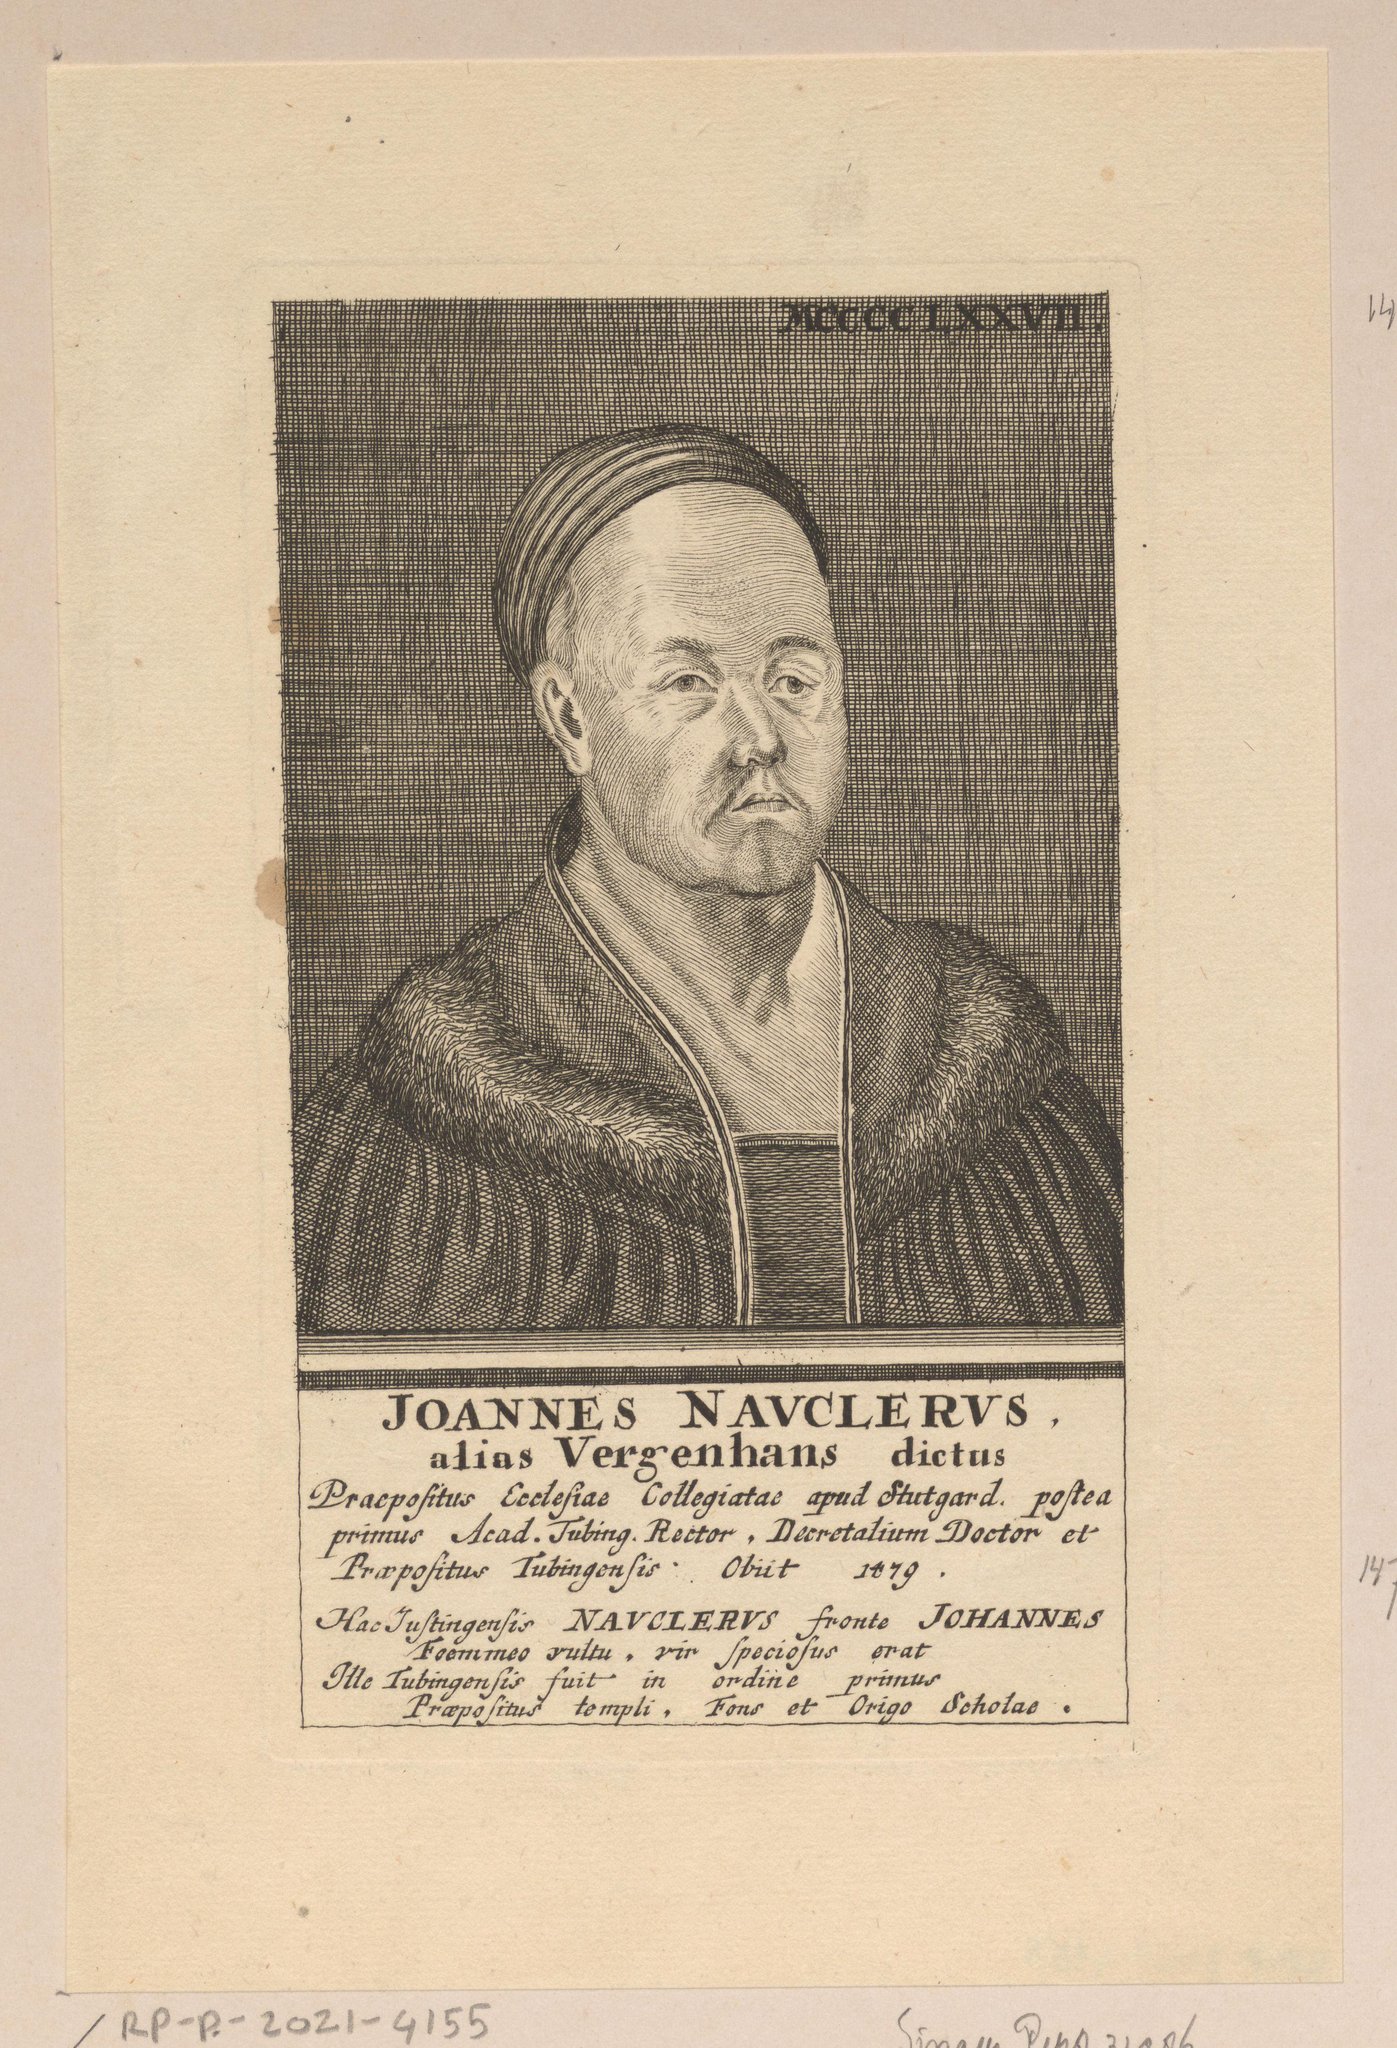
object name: print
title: Portret van Johannes Nauclerus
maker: Anonymous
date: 1700-1799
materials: paper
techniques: engraving, etching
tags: historical persons, portrait of a writer